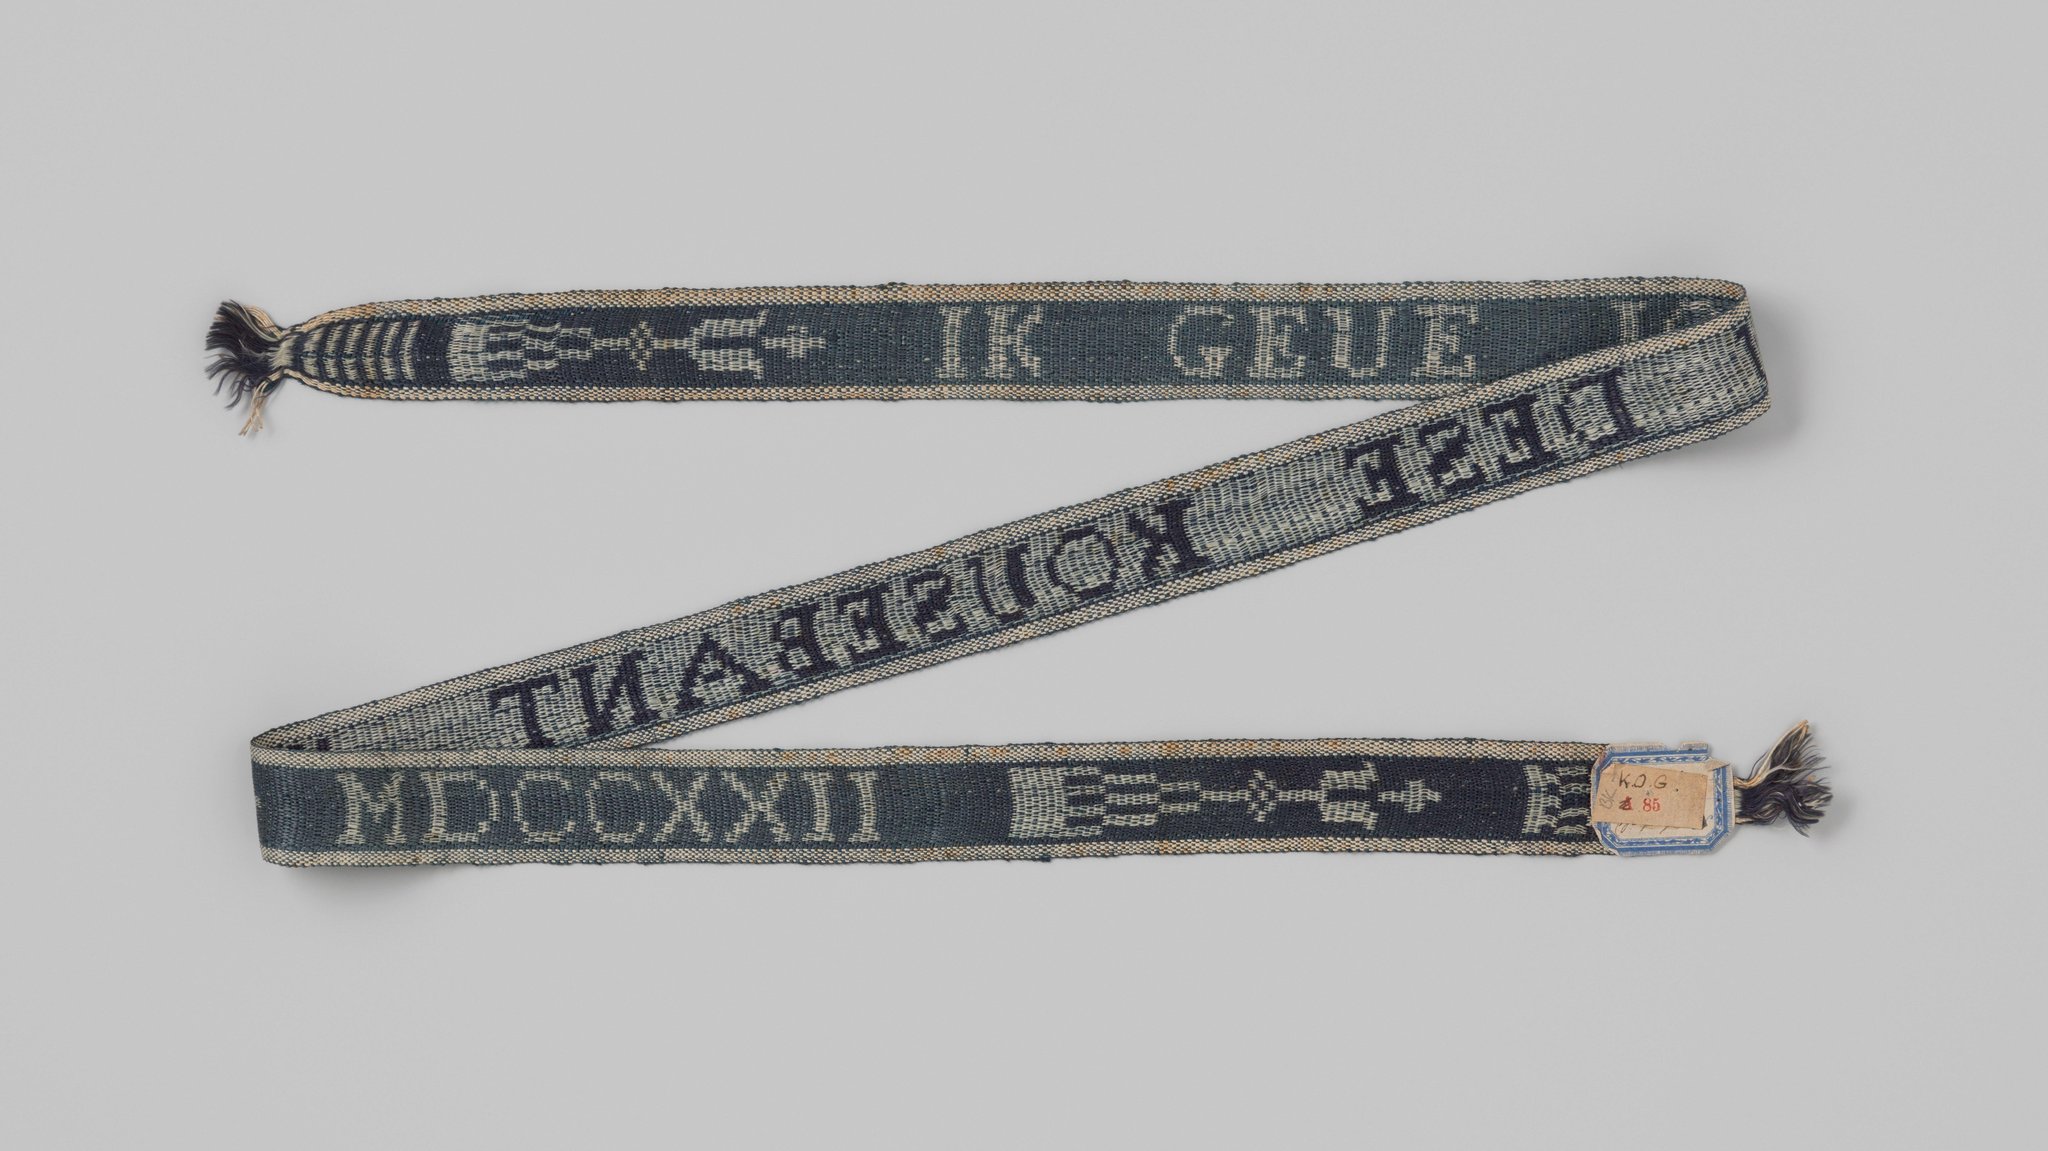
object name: clothing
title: Kousenband van witte en blauwe gebrocheerde zijde; met de tekst IK GEVE JOU DESE KOUSEBANT MDCCXXII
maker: Anonymous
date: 1722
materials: silk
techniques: brocade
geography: northern netherlands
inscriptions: inscription: ‘IK GEUE IOU DESE KOUSEBANT MDCCXXII’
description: Kousenband van witte en blauwe gebrocheerde zijde. Over de hele lengte van de kousenband staat de tekst: IK GEUE IOU DESE KOUSEBANT MDCCXXII. Tussen opschrift en het jaartal een keizerskroon.